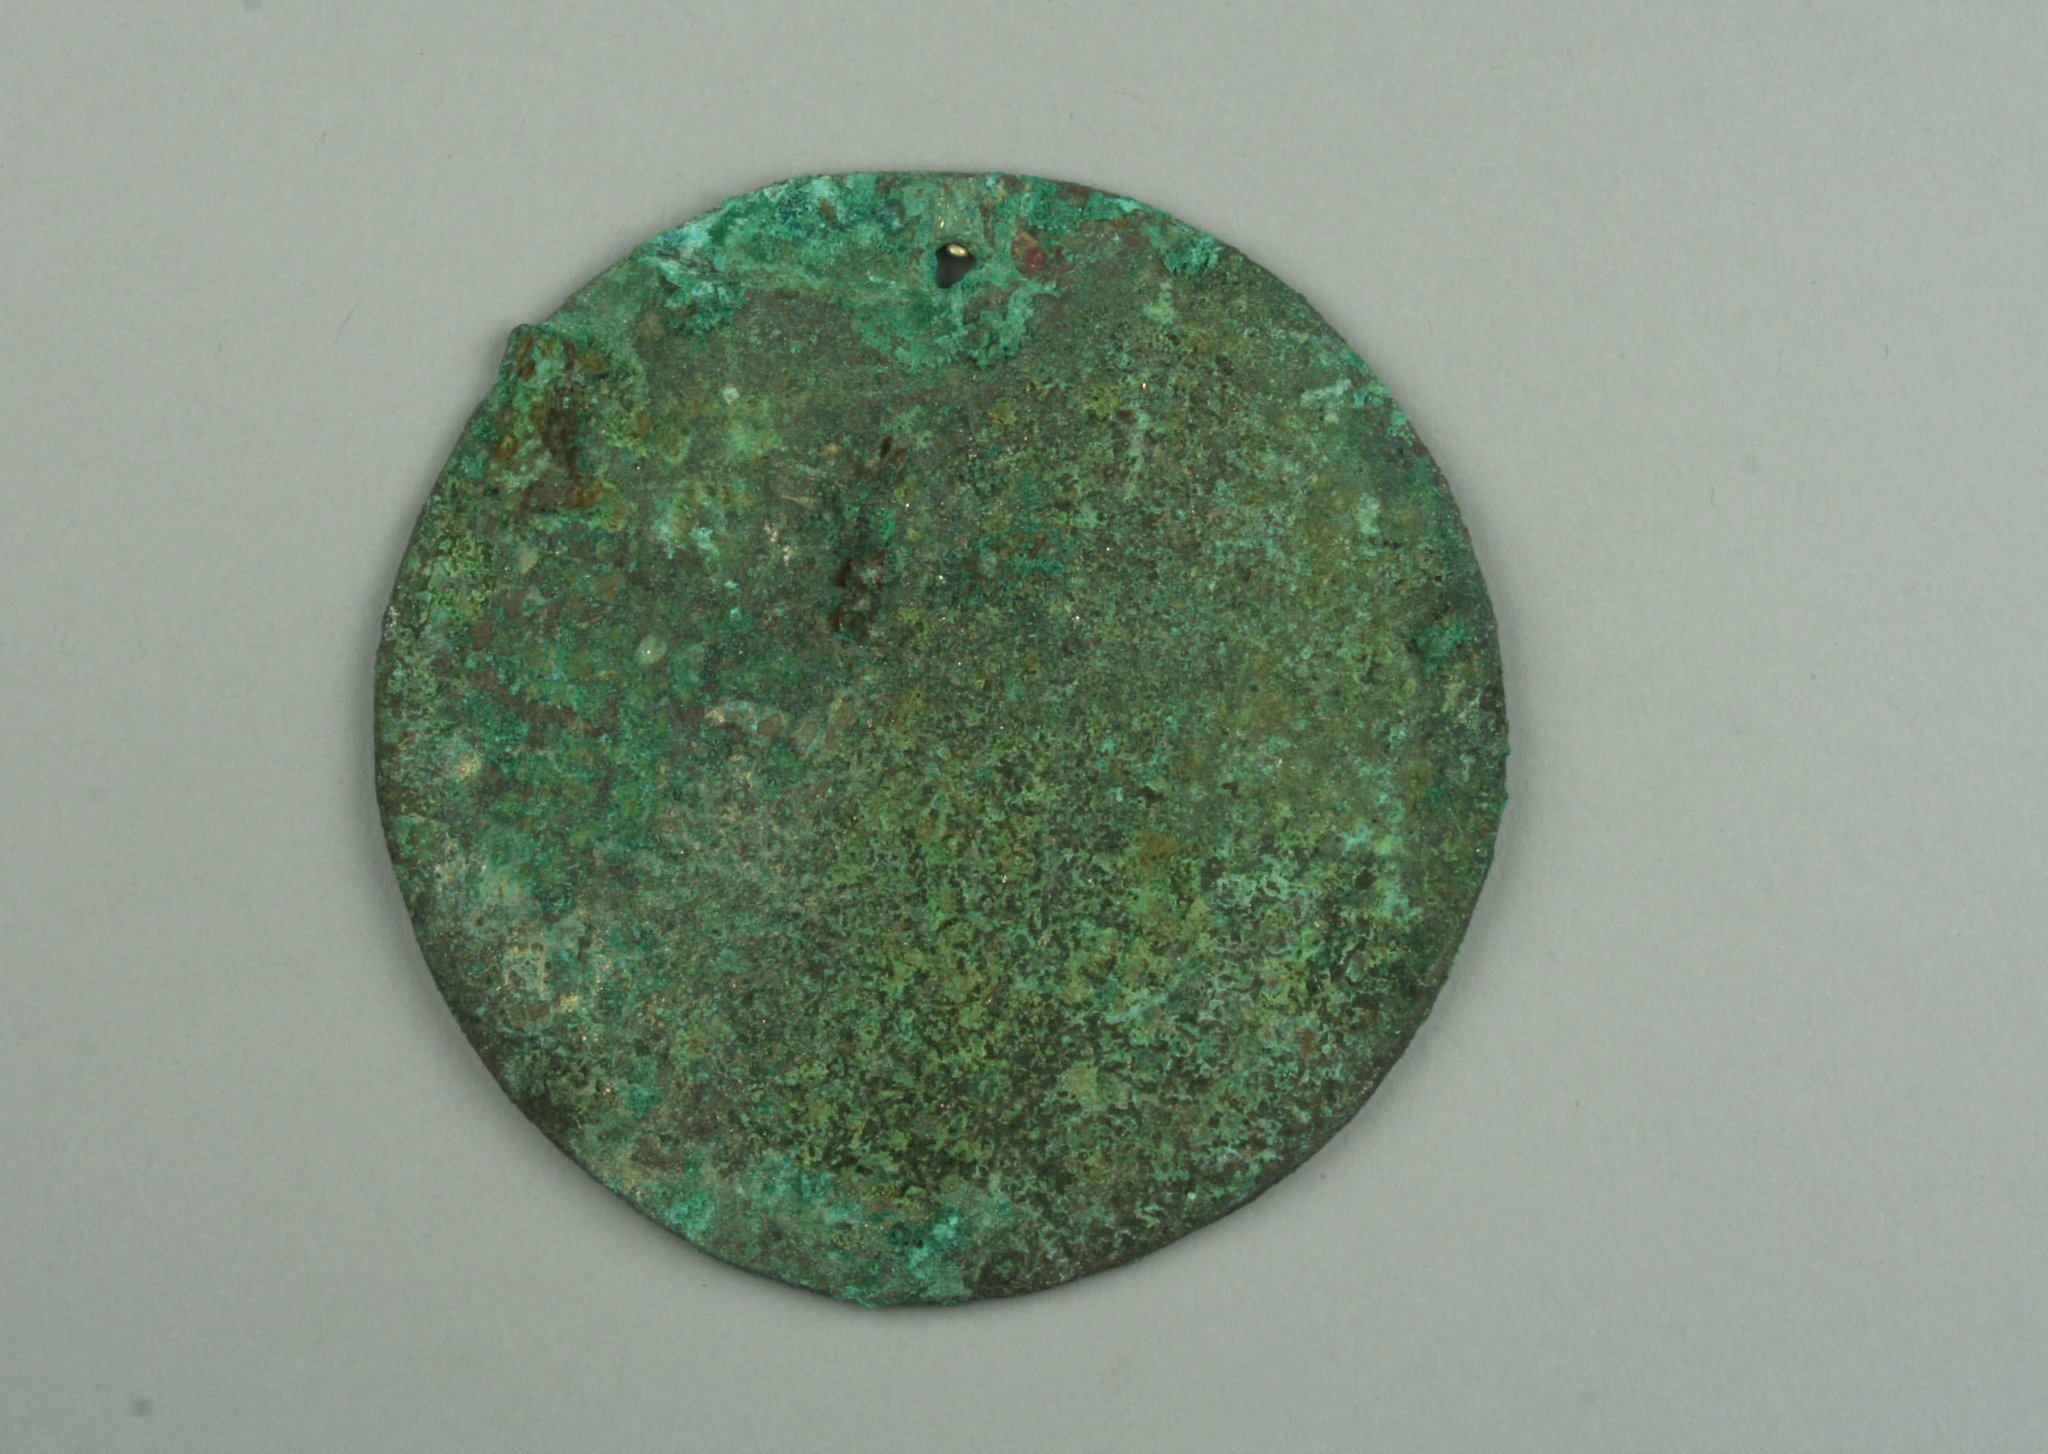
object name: plaque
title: Round Plaque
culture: vicús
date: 300 BCE-200 CE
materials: copper, gilt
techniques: hammering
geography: peru